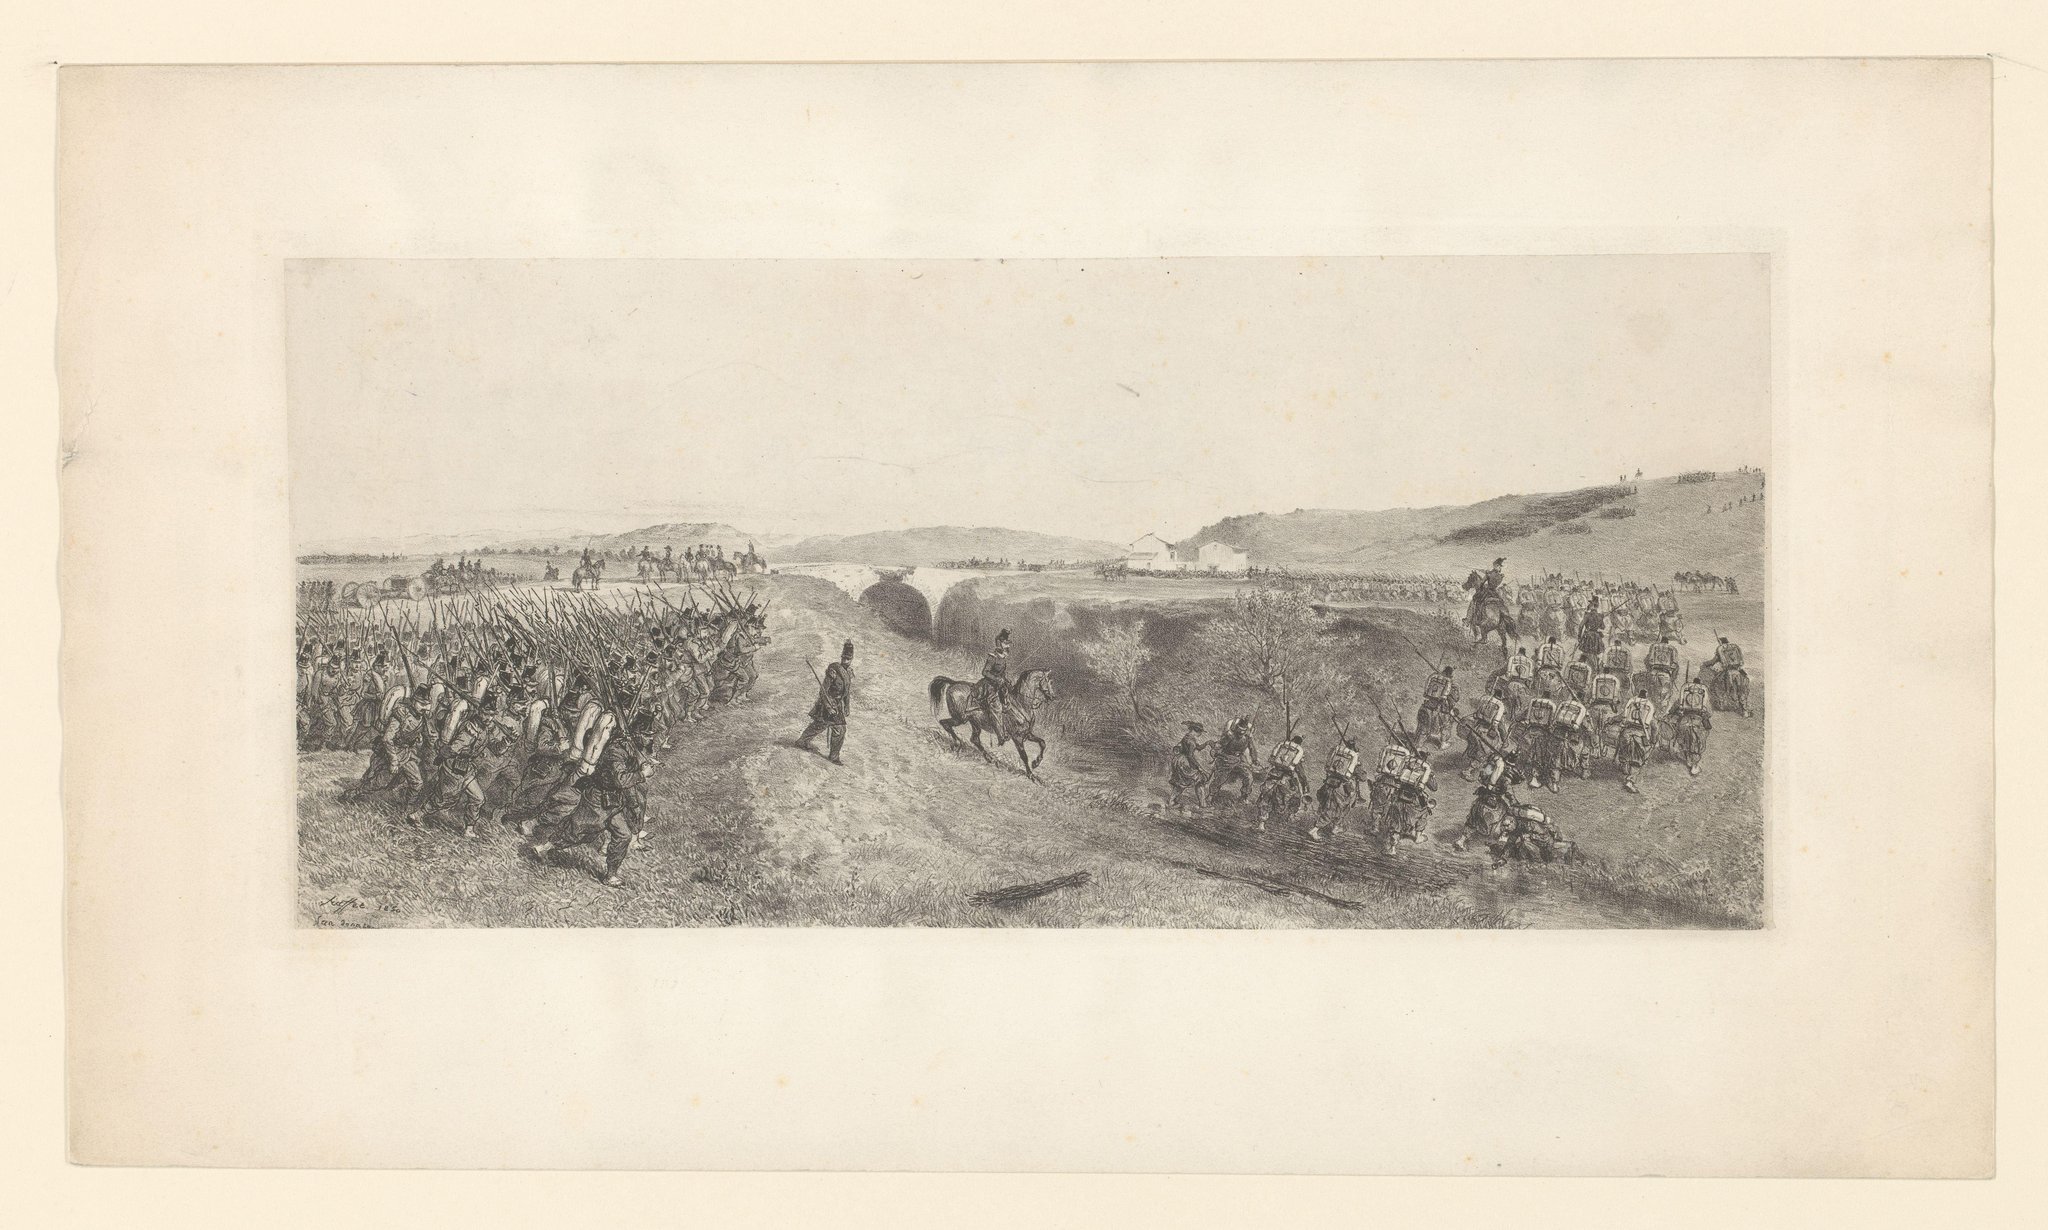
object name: print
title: Expédition et siége de Rome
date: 1850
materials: paper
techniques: lithograph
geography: paris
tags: landscapes, river, the soldier; the soldier's life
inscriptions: collector's mark: Lugt 964, collector's mark: Lugt 2760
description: Prent is waarschijnlijk proefdruk waardoor serienummer ontbreekt. Dit is waarschijnlijk nummer vier van de 36 prenten.